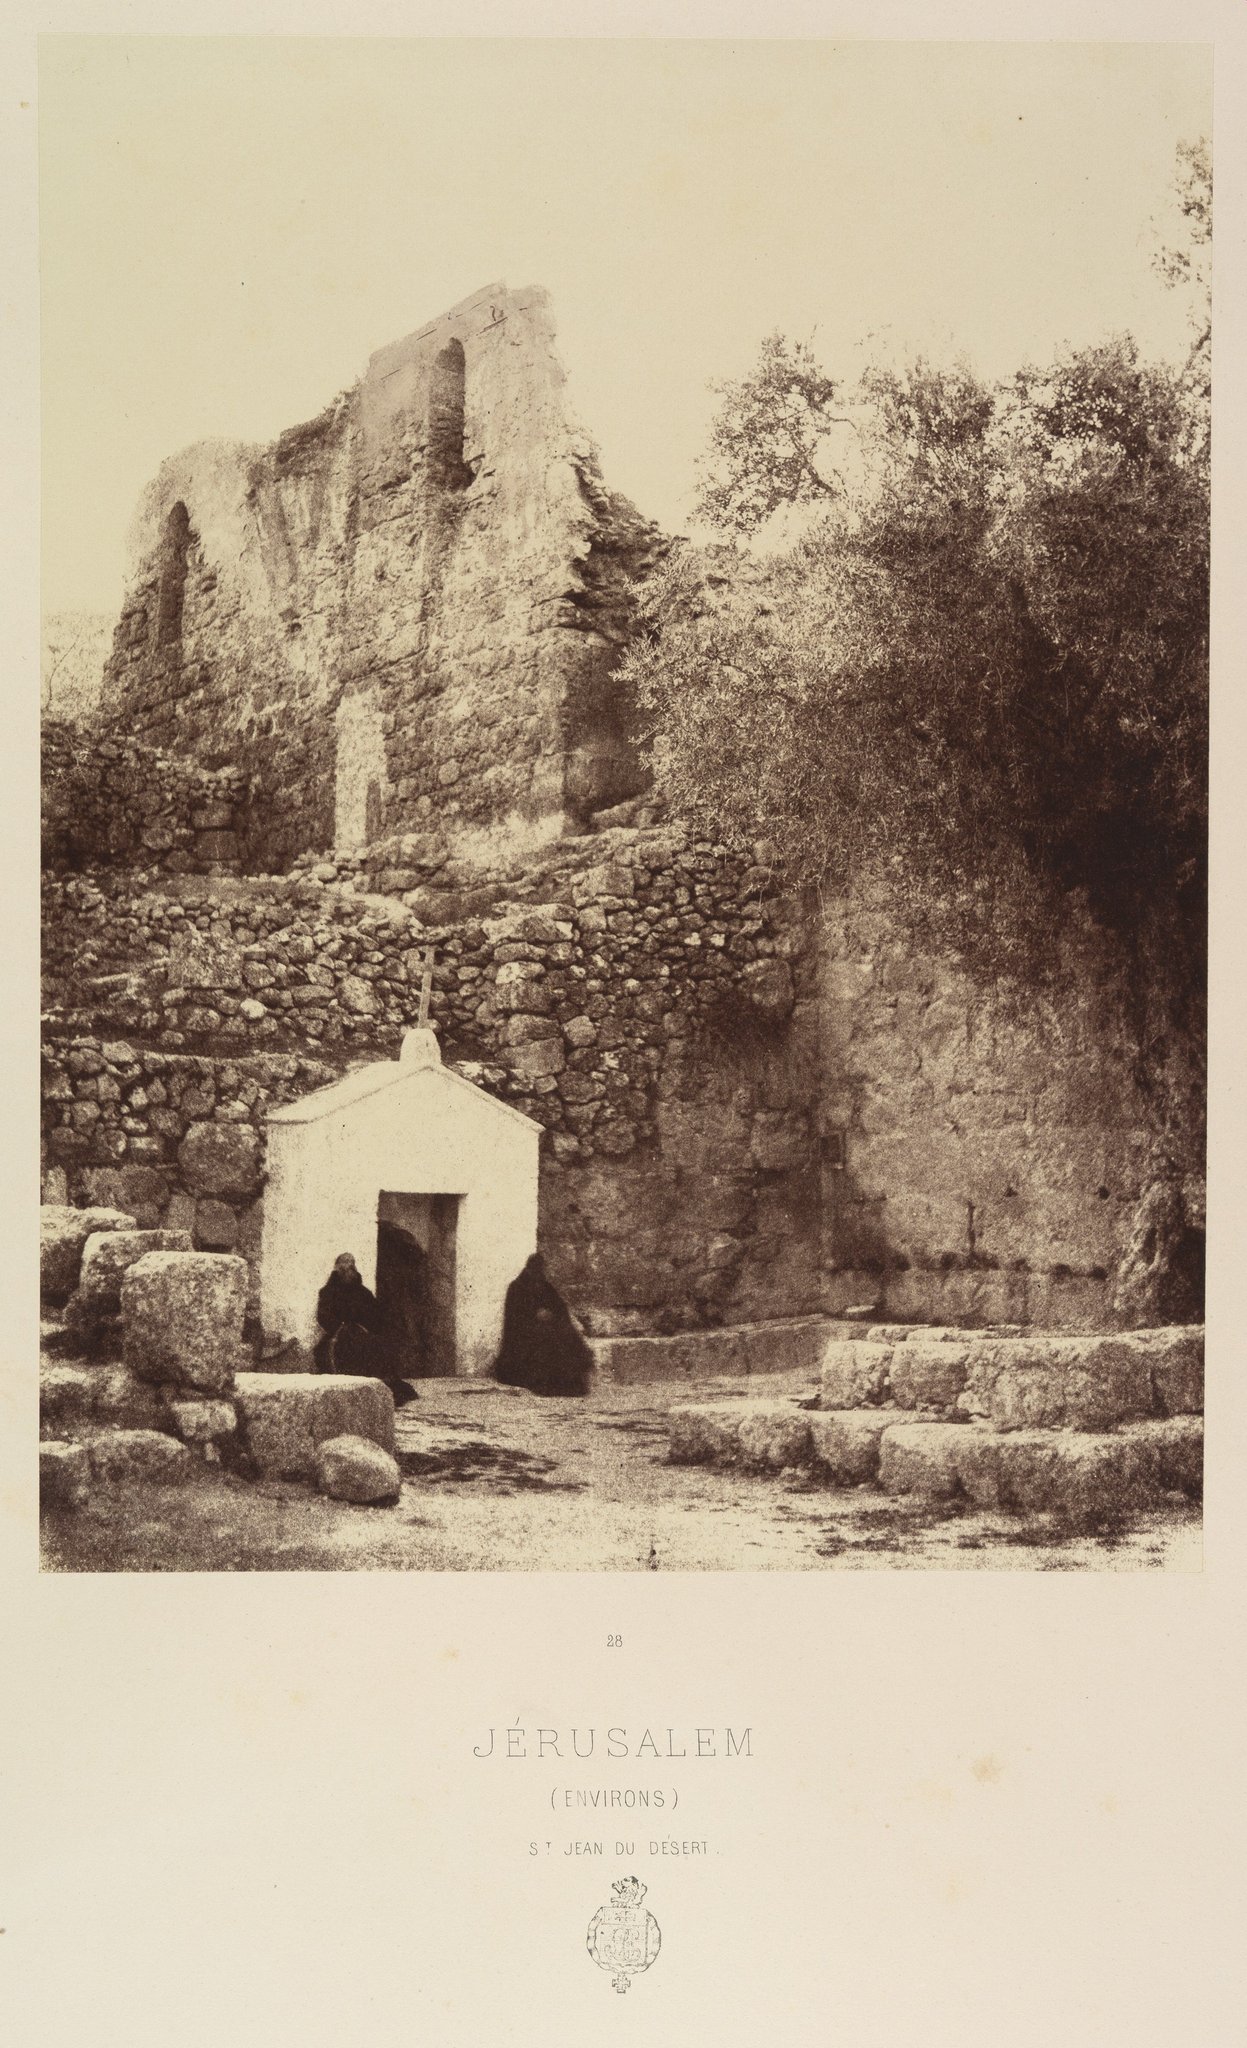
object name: photograph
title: Jérusalem. (Environs) St Jean du Désert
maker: louis de clercq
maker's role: artist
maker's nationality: french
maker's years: 1837-1901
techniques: albumen silver print, paper negative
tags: architecture,ruins